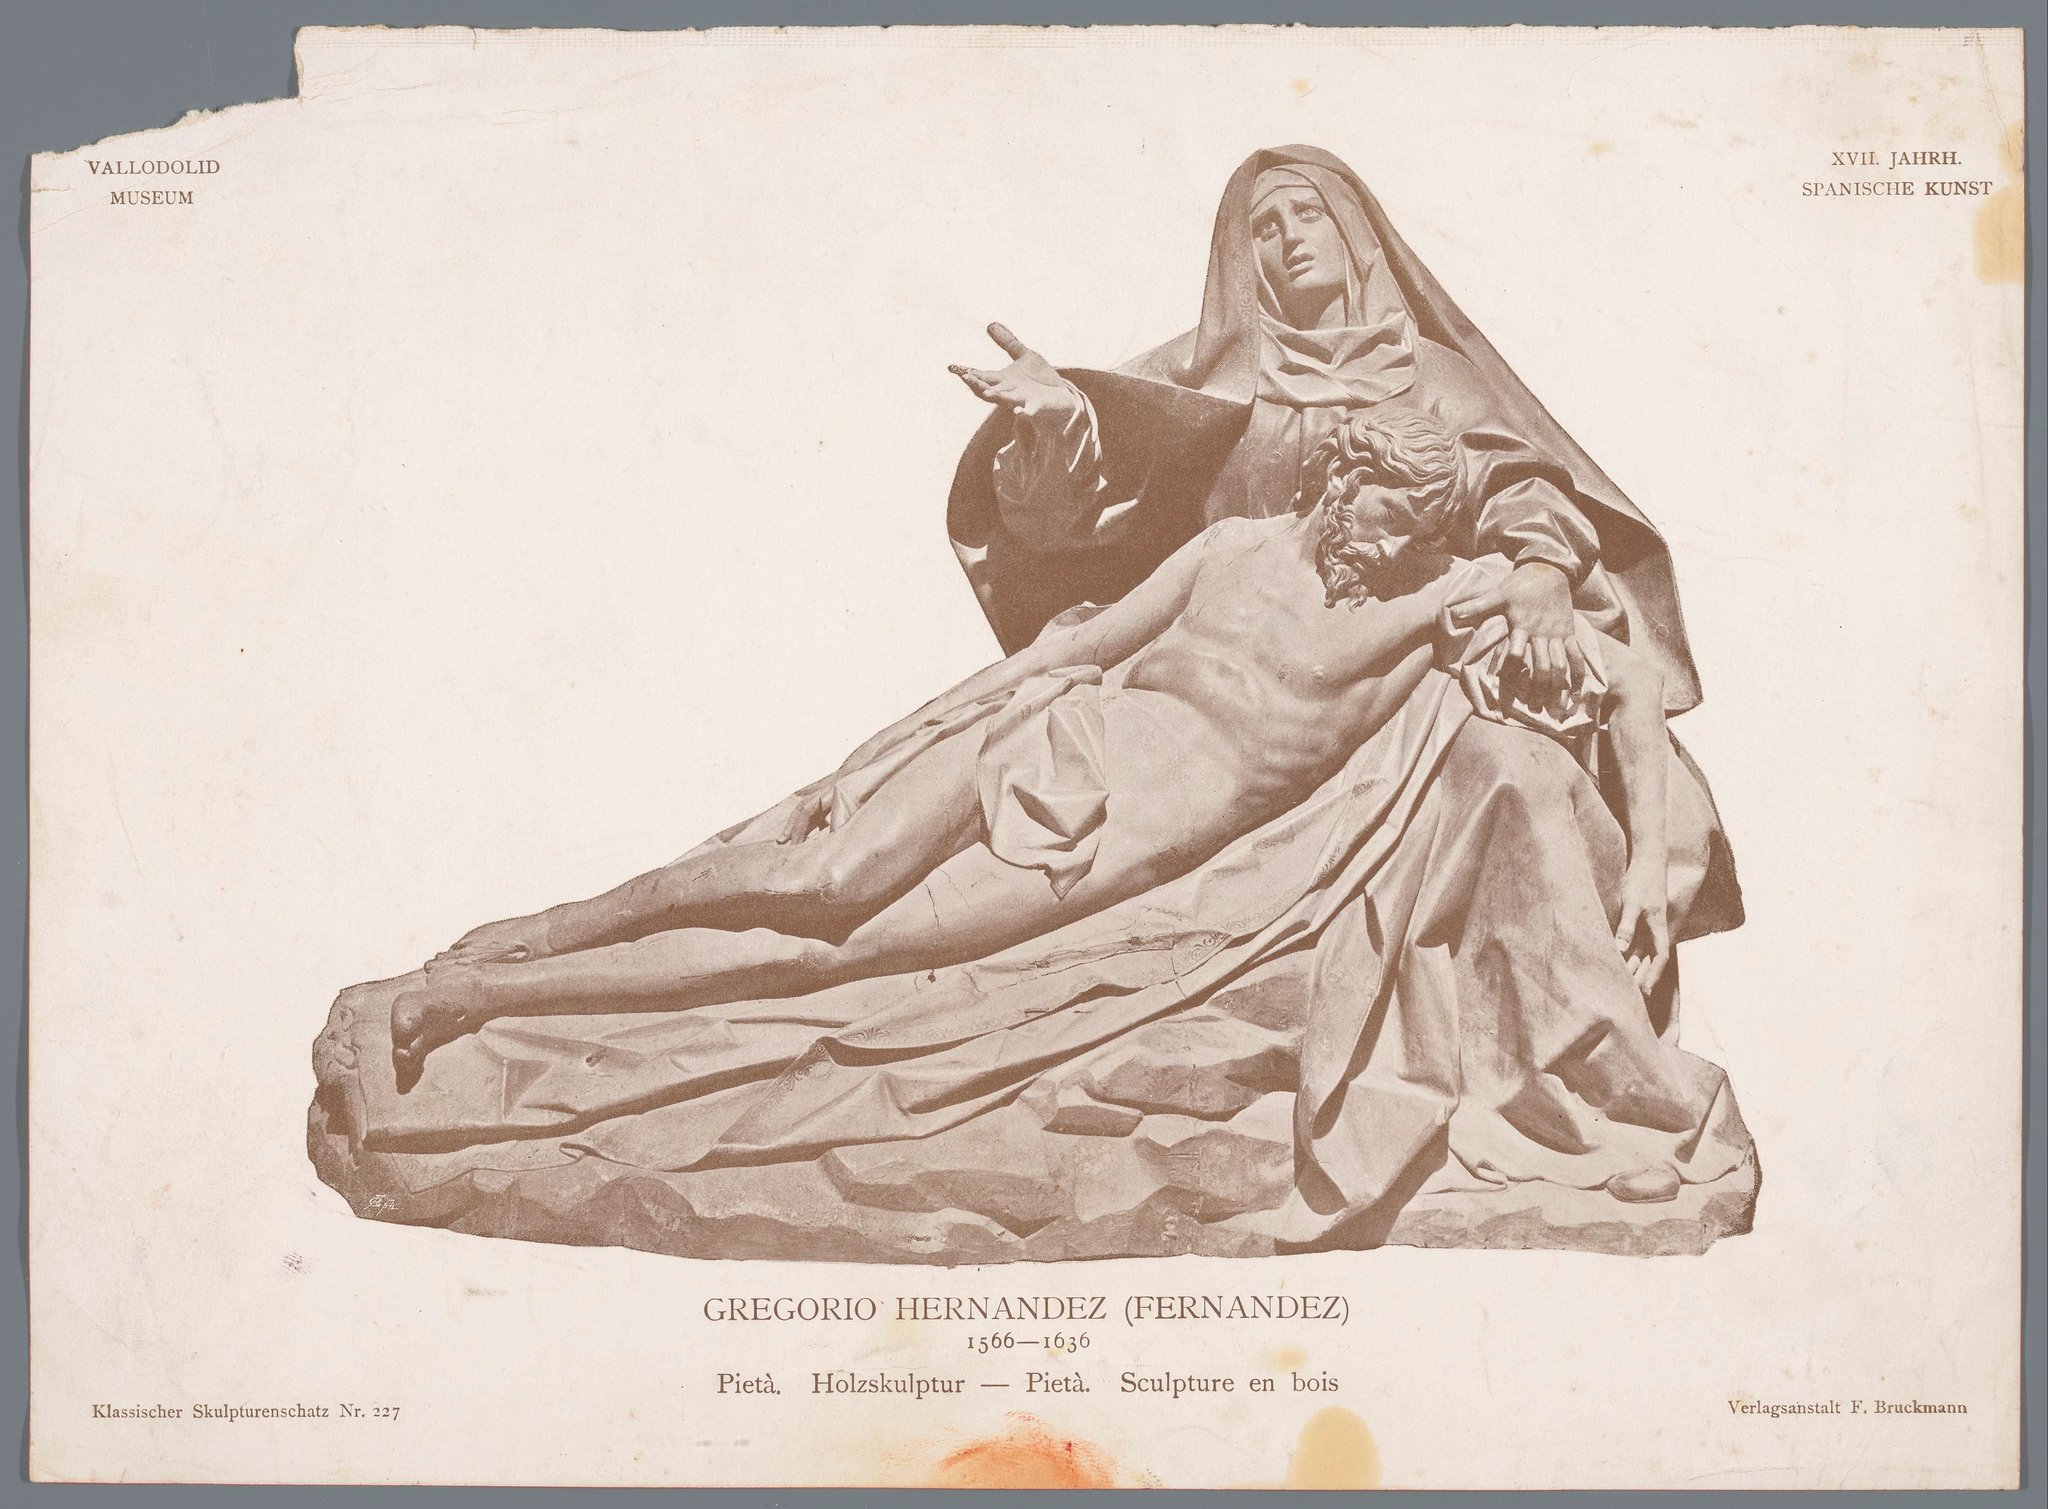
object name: reproduction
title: GREGORIO HERNANDEZ (FERNANDEZ) 1566-1636 Pietà. Holzskulptur - Pietà. Sculpture en bois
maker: Anonymous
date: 1875-1900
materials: paper, ink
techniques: photochemical processes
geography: europe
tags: 'pietas'; 'pietà' (ripa), europe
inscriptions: number: ‘Klassischer Skulpturenschatz Nr. 227’, inscription: ‘VALLODOLID MUSEUM’, inscription: ‘XVII. JAHRH. SPANISCHE KUNST’